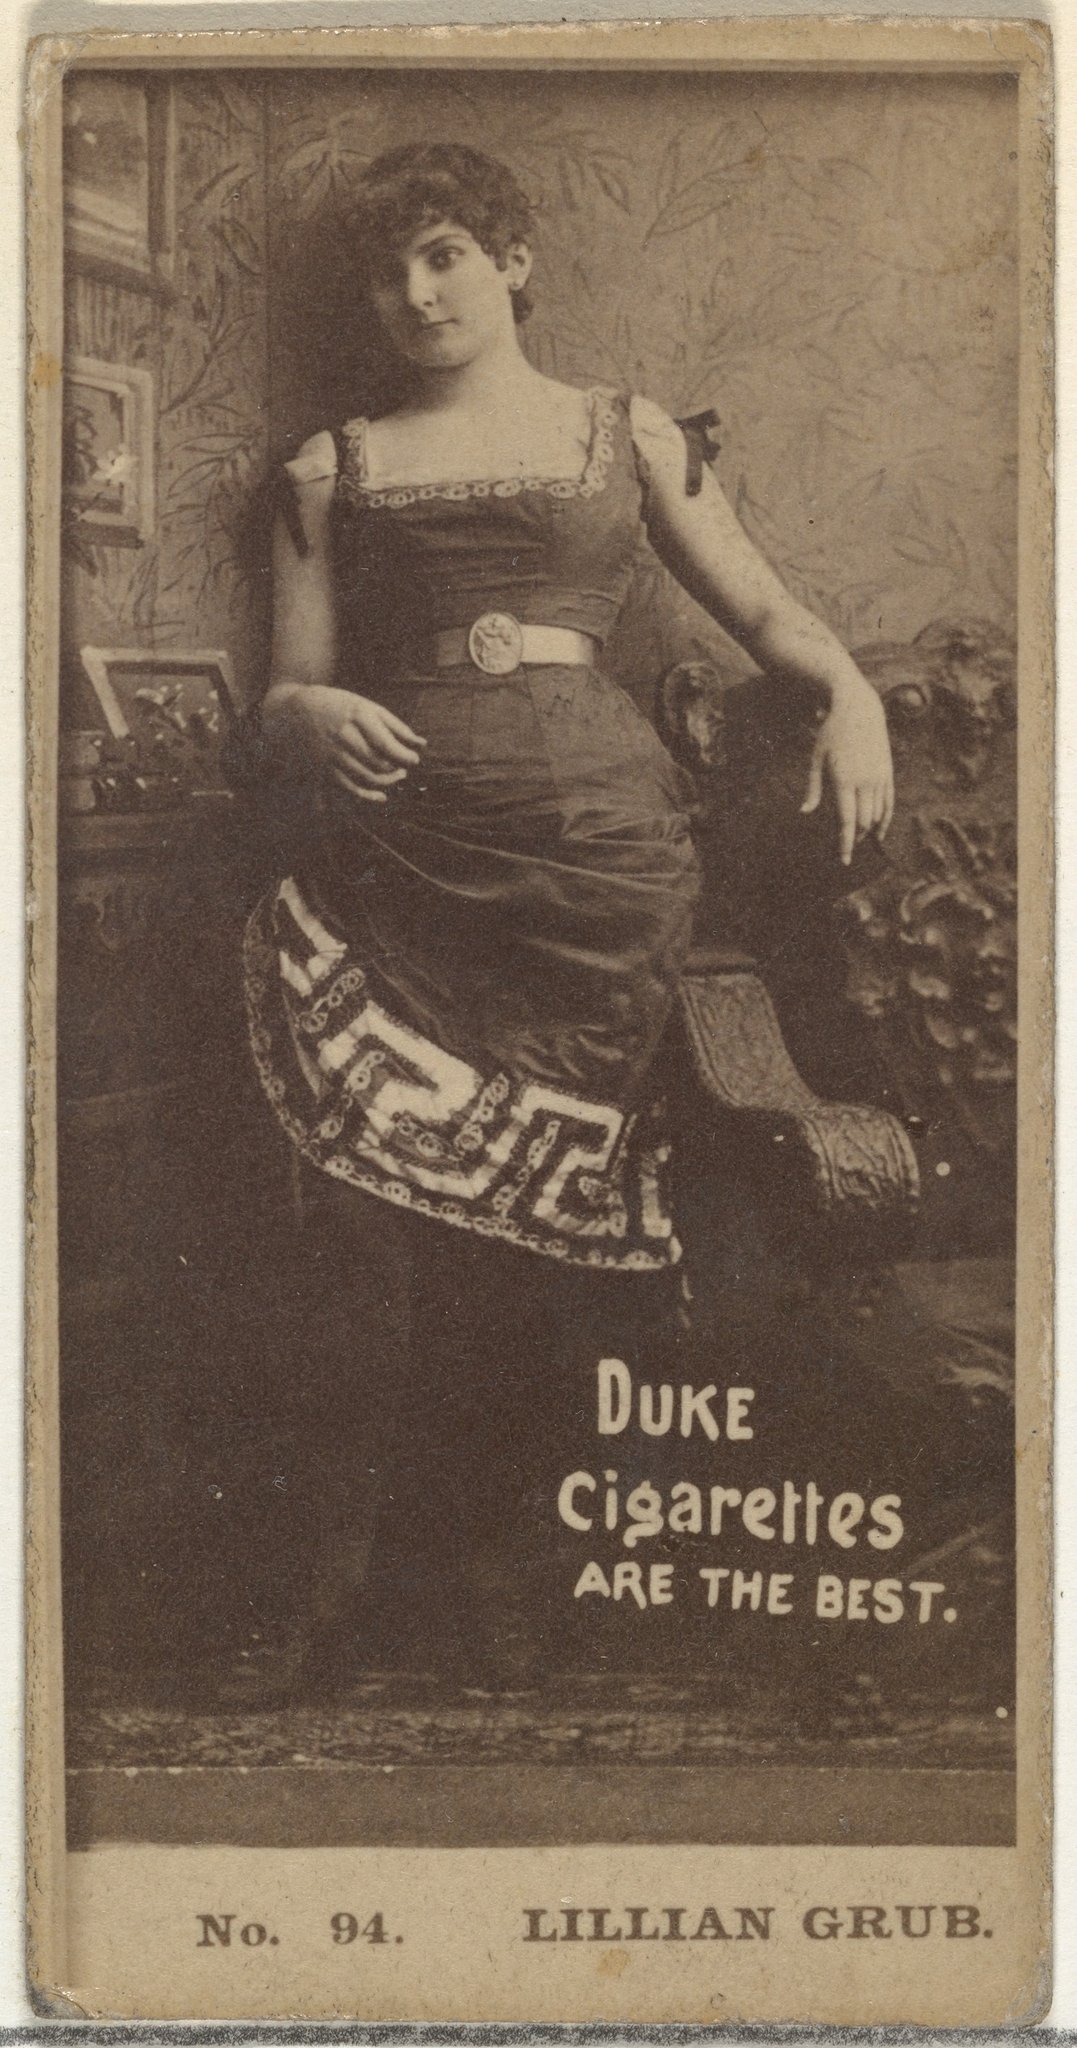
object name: photograph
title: Card Number 94, Lillian Grubb, from the Actors and Actresses series (N145-6) issued by Duke Sons & Co. to promote Duke Cigarettes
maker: w. duke, sons & co.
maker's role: publisher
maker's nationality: american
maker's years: 1870-1920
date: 1880-1889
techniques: albumen silver print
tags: portraits,women,actresses